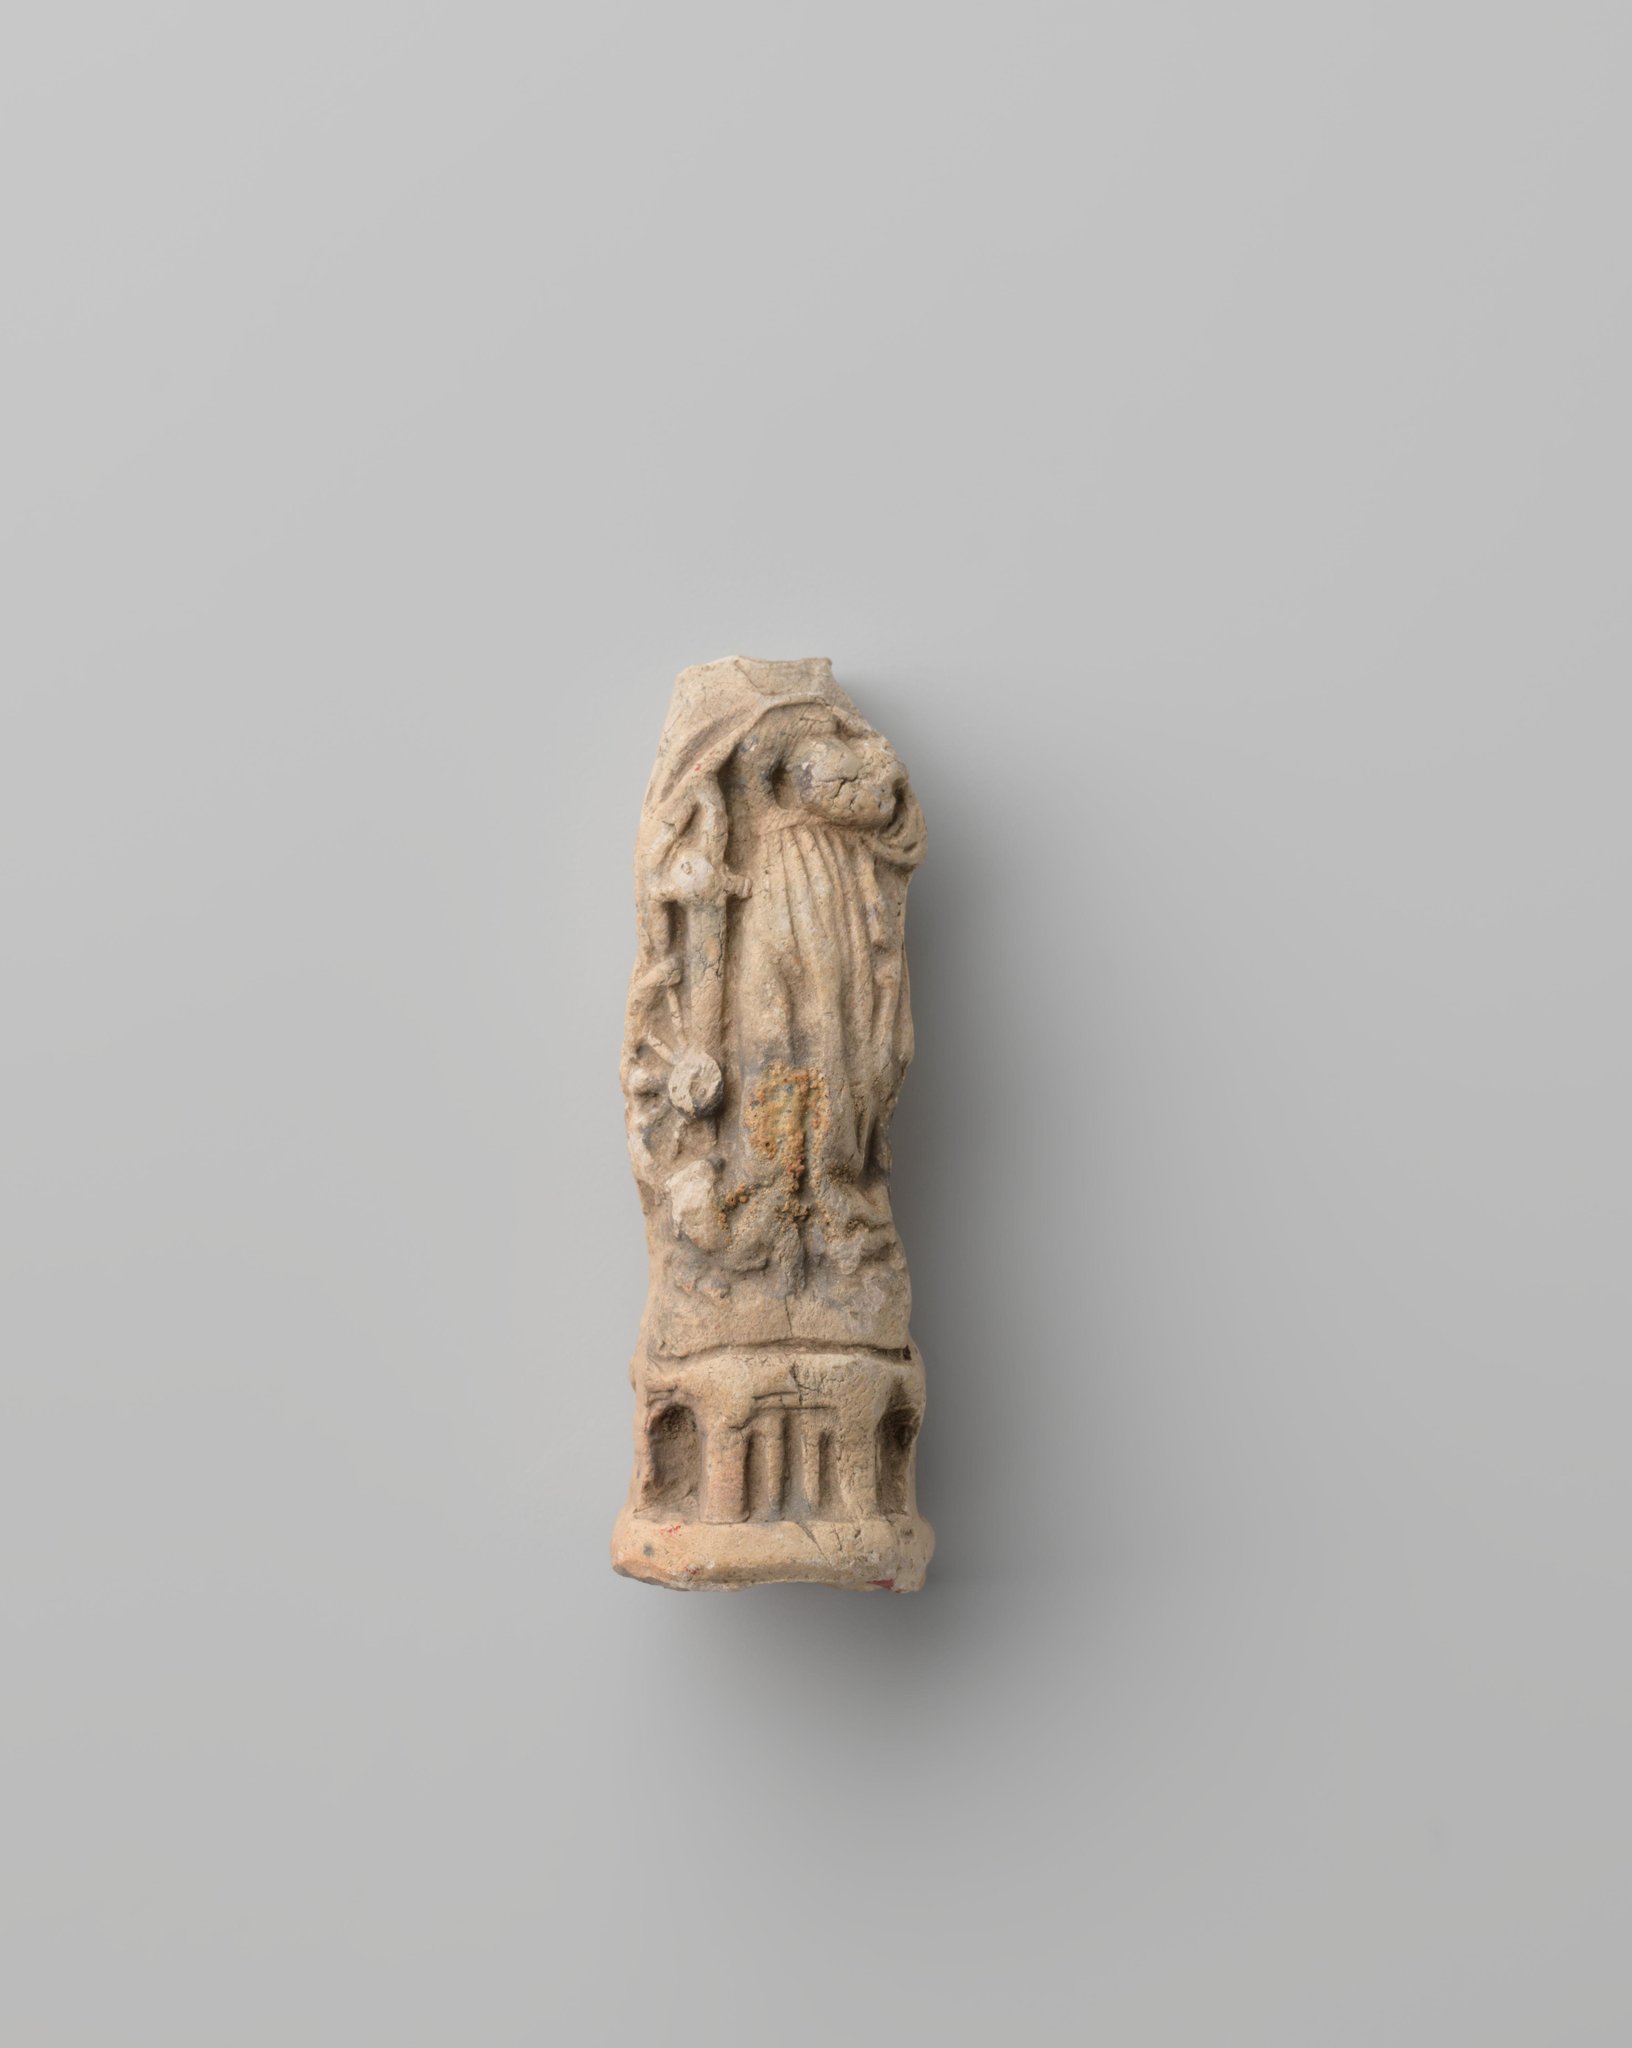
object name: sculpture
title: St Catherine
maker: Anonymous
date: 1425-1450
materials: clay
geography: utrecht